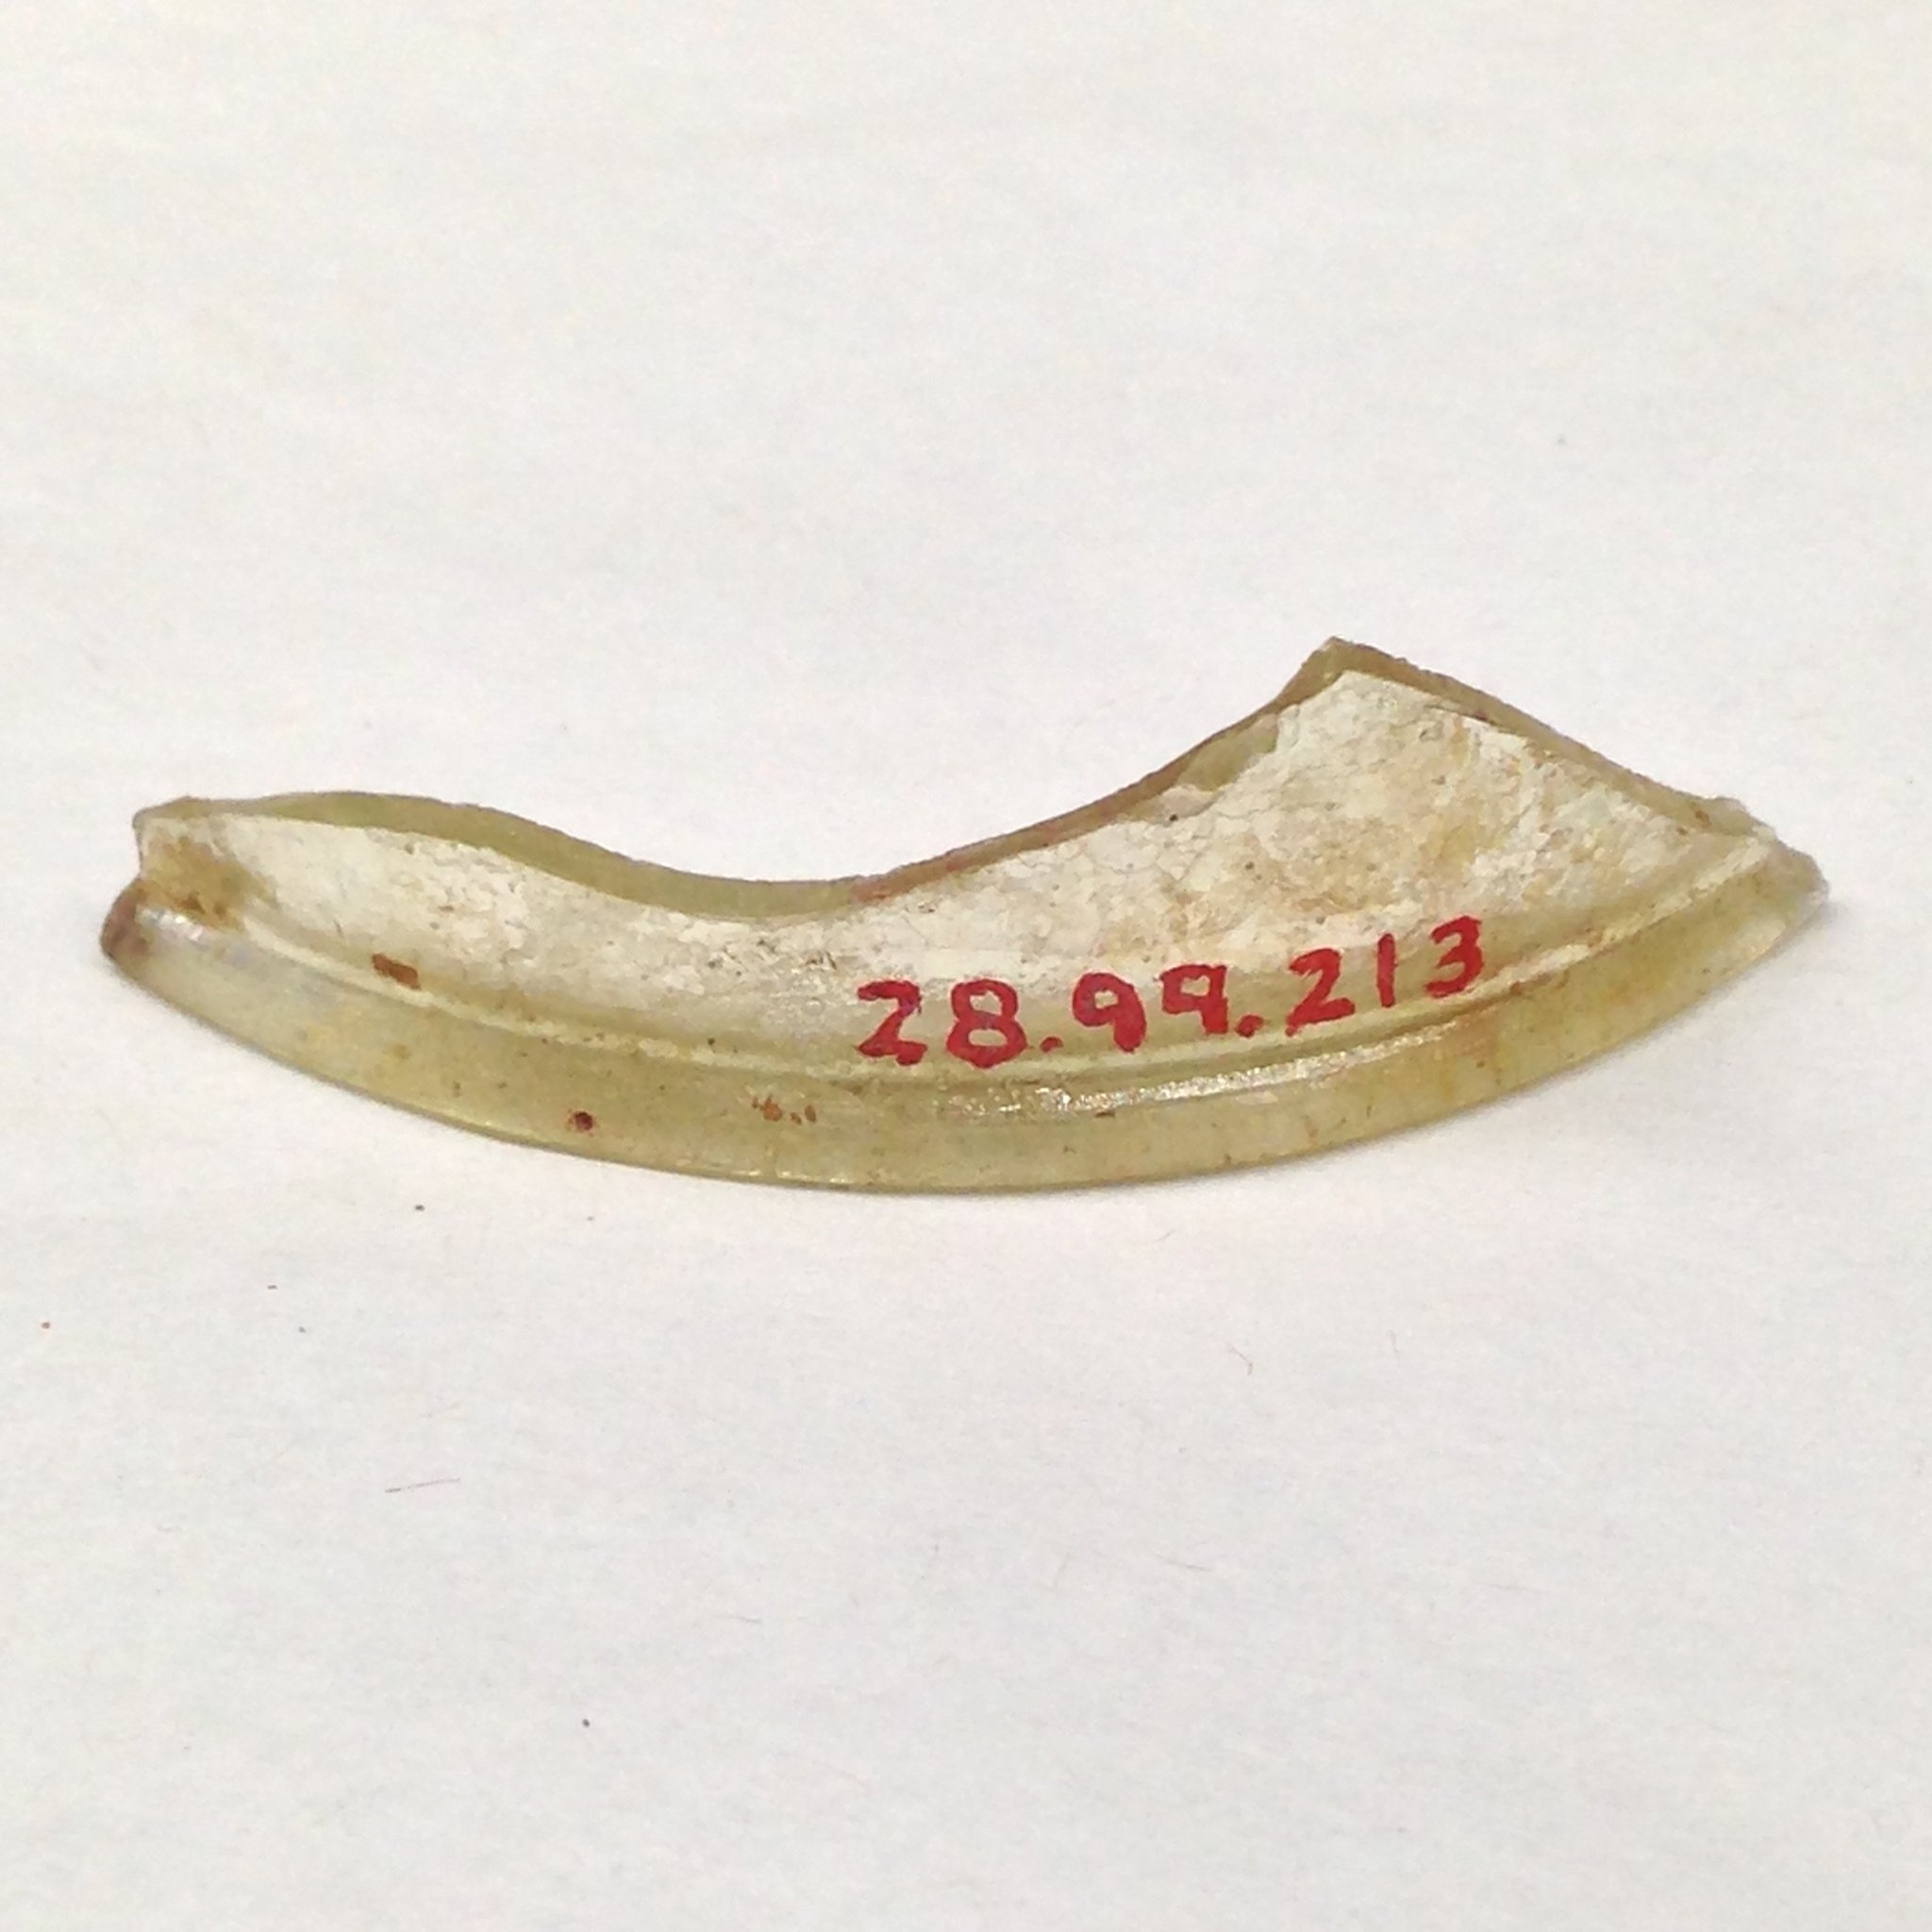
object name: fragment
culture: european or middle eastern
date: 1150-1250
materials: ceramic, glass